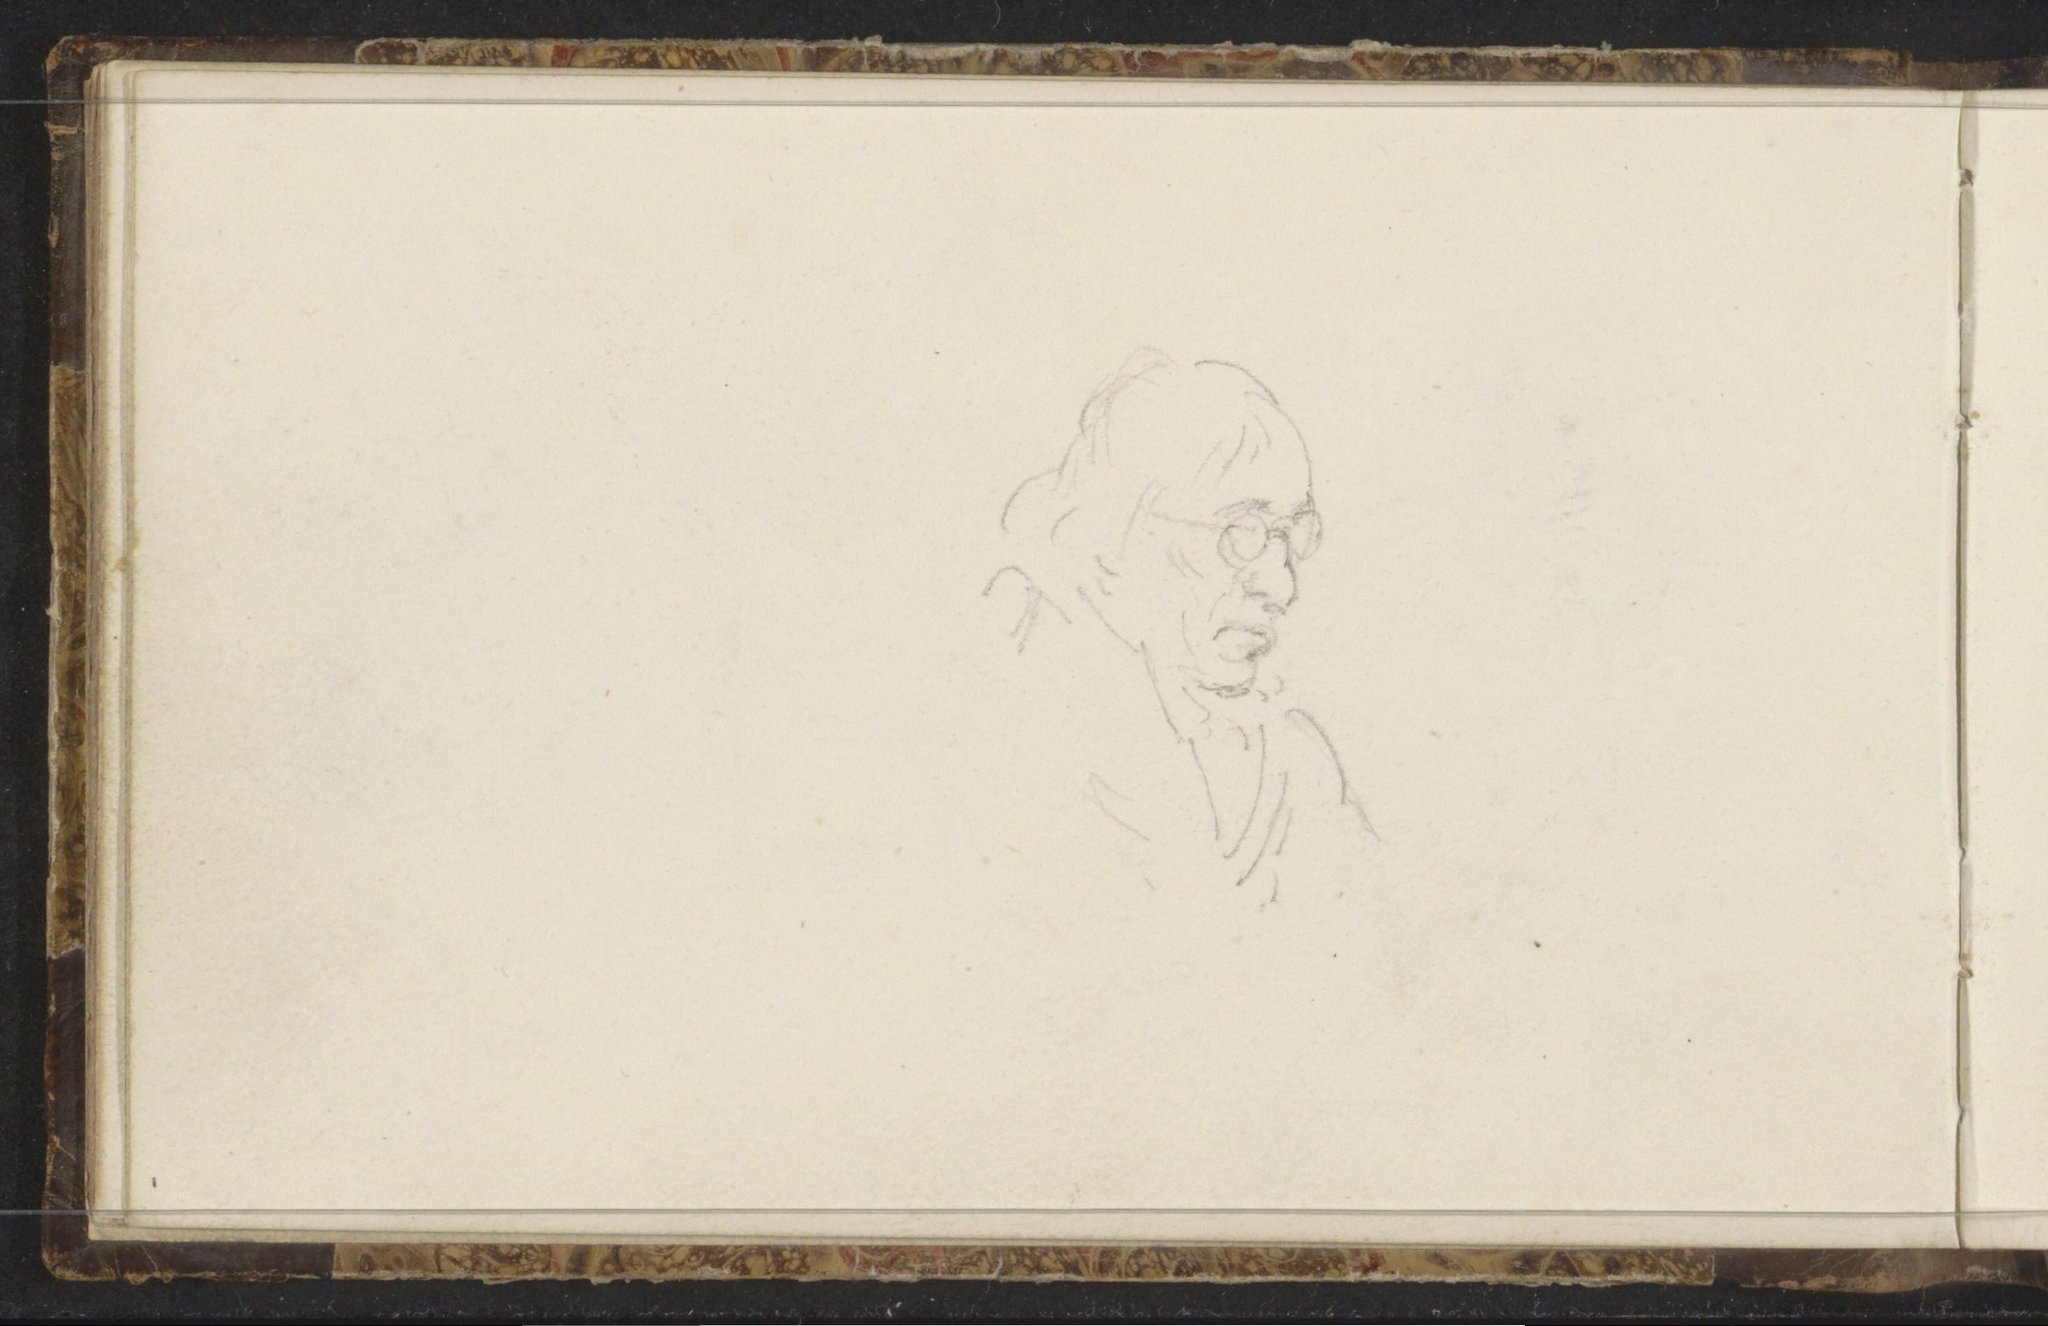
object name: sketchbook leaf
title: Hoofd van een man met bril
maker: willem hendrik schmidt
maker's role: draughtsman, painter, print maker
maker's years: 1809-1849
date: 1819-1849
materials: paper, pencil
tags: eyeglasses, spectacles, head (human) (+ right side visible; right - (r. hand, r. foot, etc.))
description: Blad 9 verso uit een schetsboek met 60 bladen.